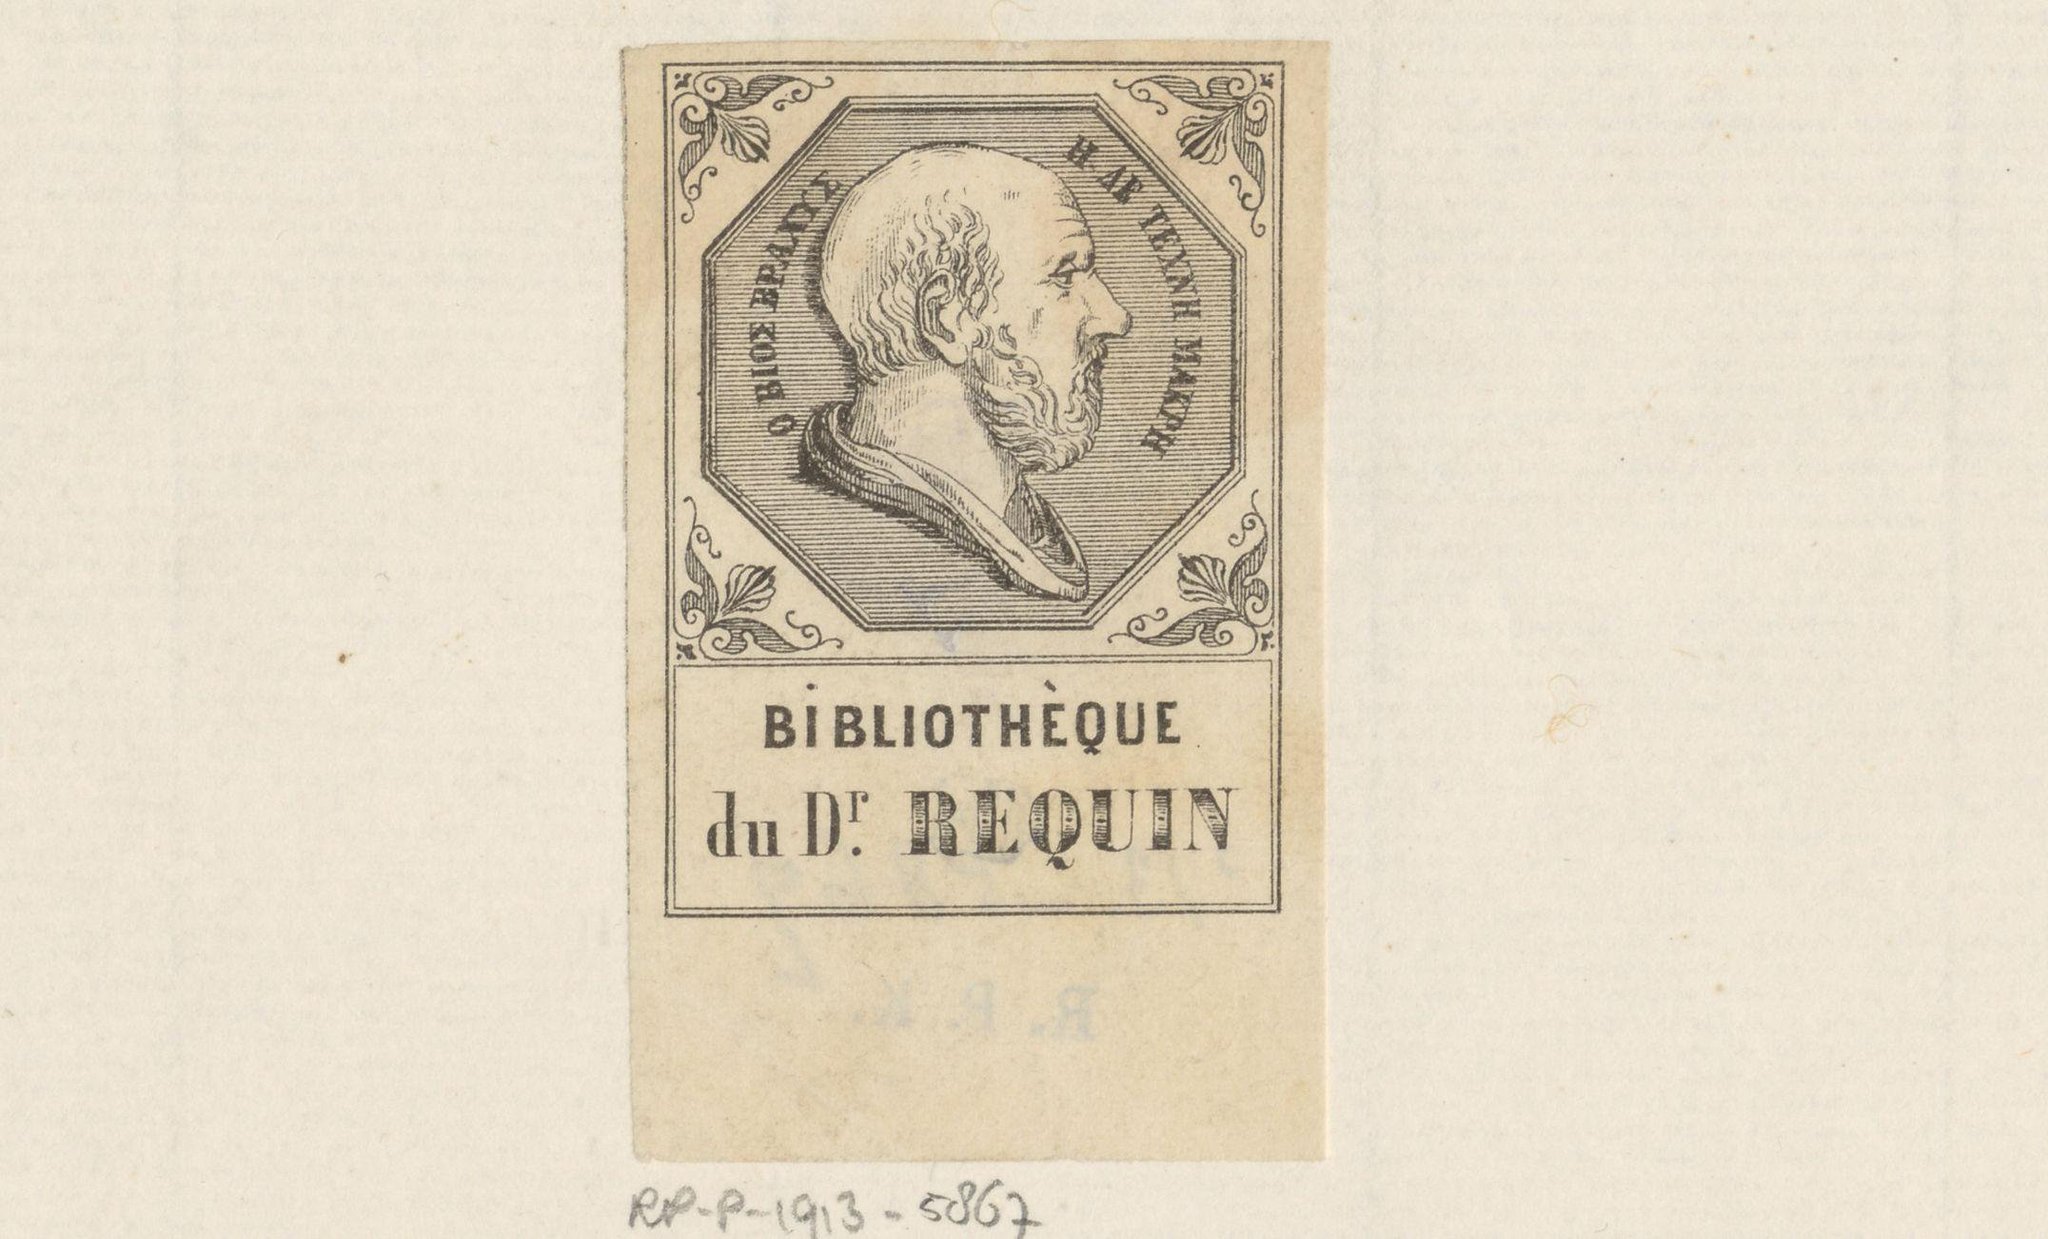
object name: bookplate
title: Ex libris van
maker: Anonymous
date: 1813-1854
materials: paper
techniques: lithograph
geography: france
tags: lyon, paris, historical persons, old man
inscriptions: collector's mark: Lugt 2233, collector's mark: ‘V’, collector's mark: Lugt 2760